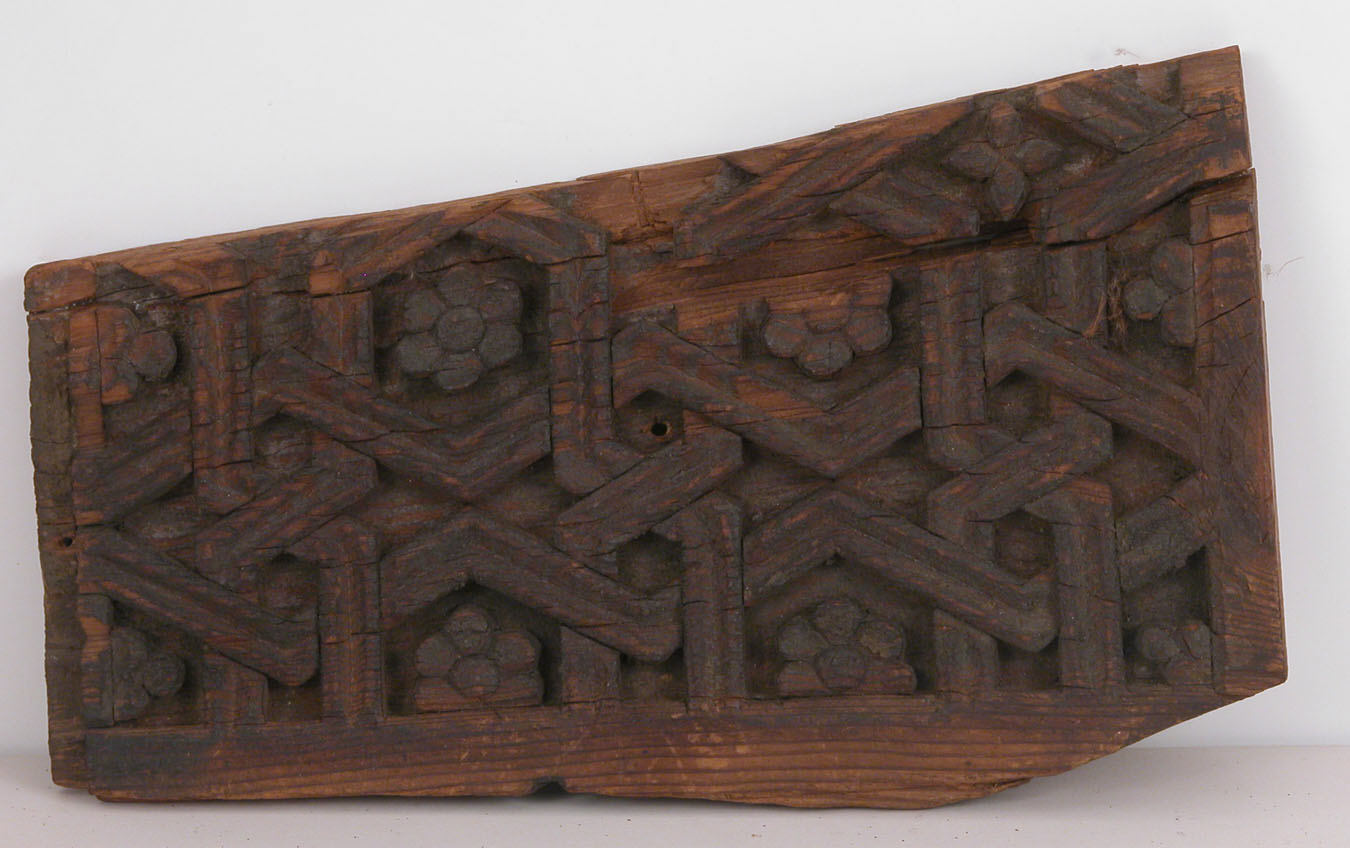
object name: panel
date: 1301-1400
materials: wood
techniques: carving, painting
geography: spain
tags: flowers